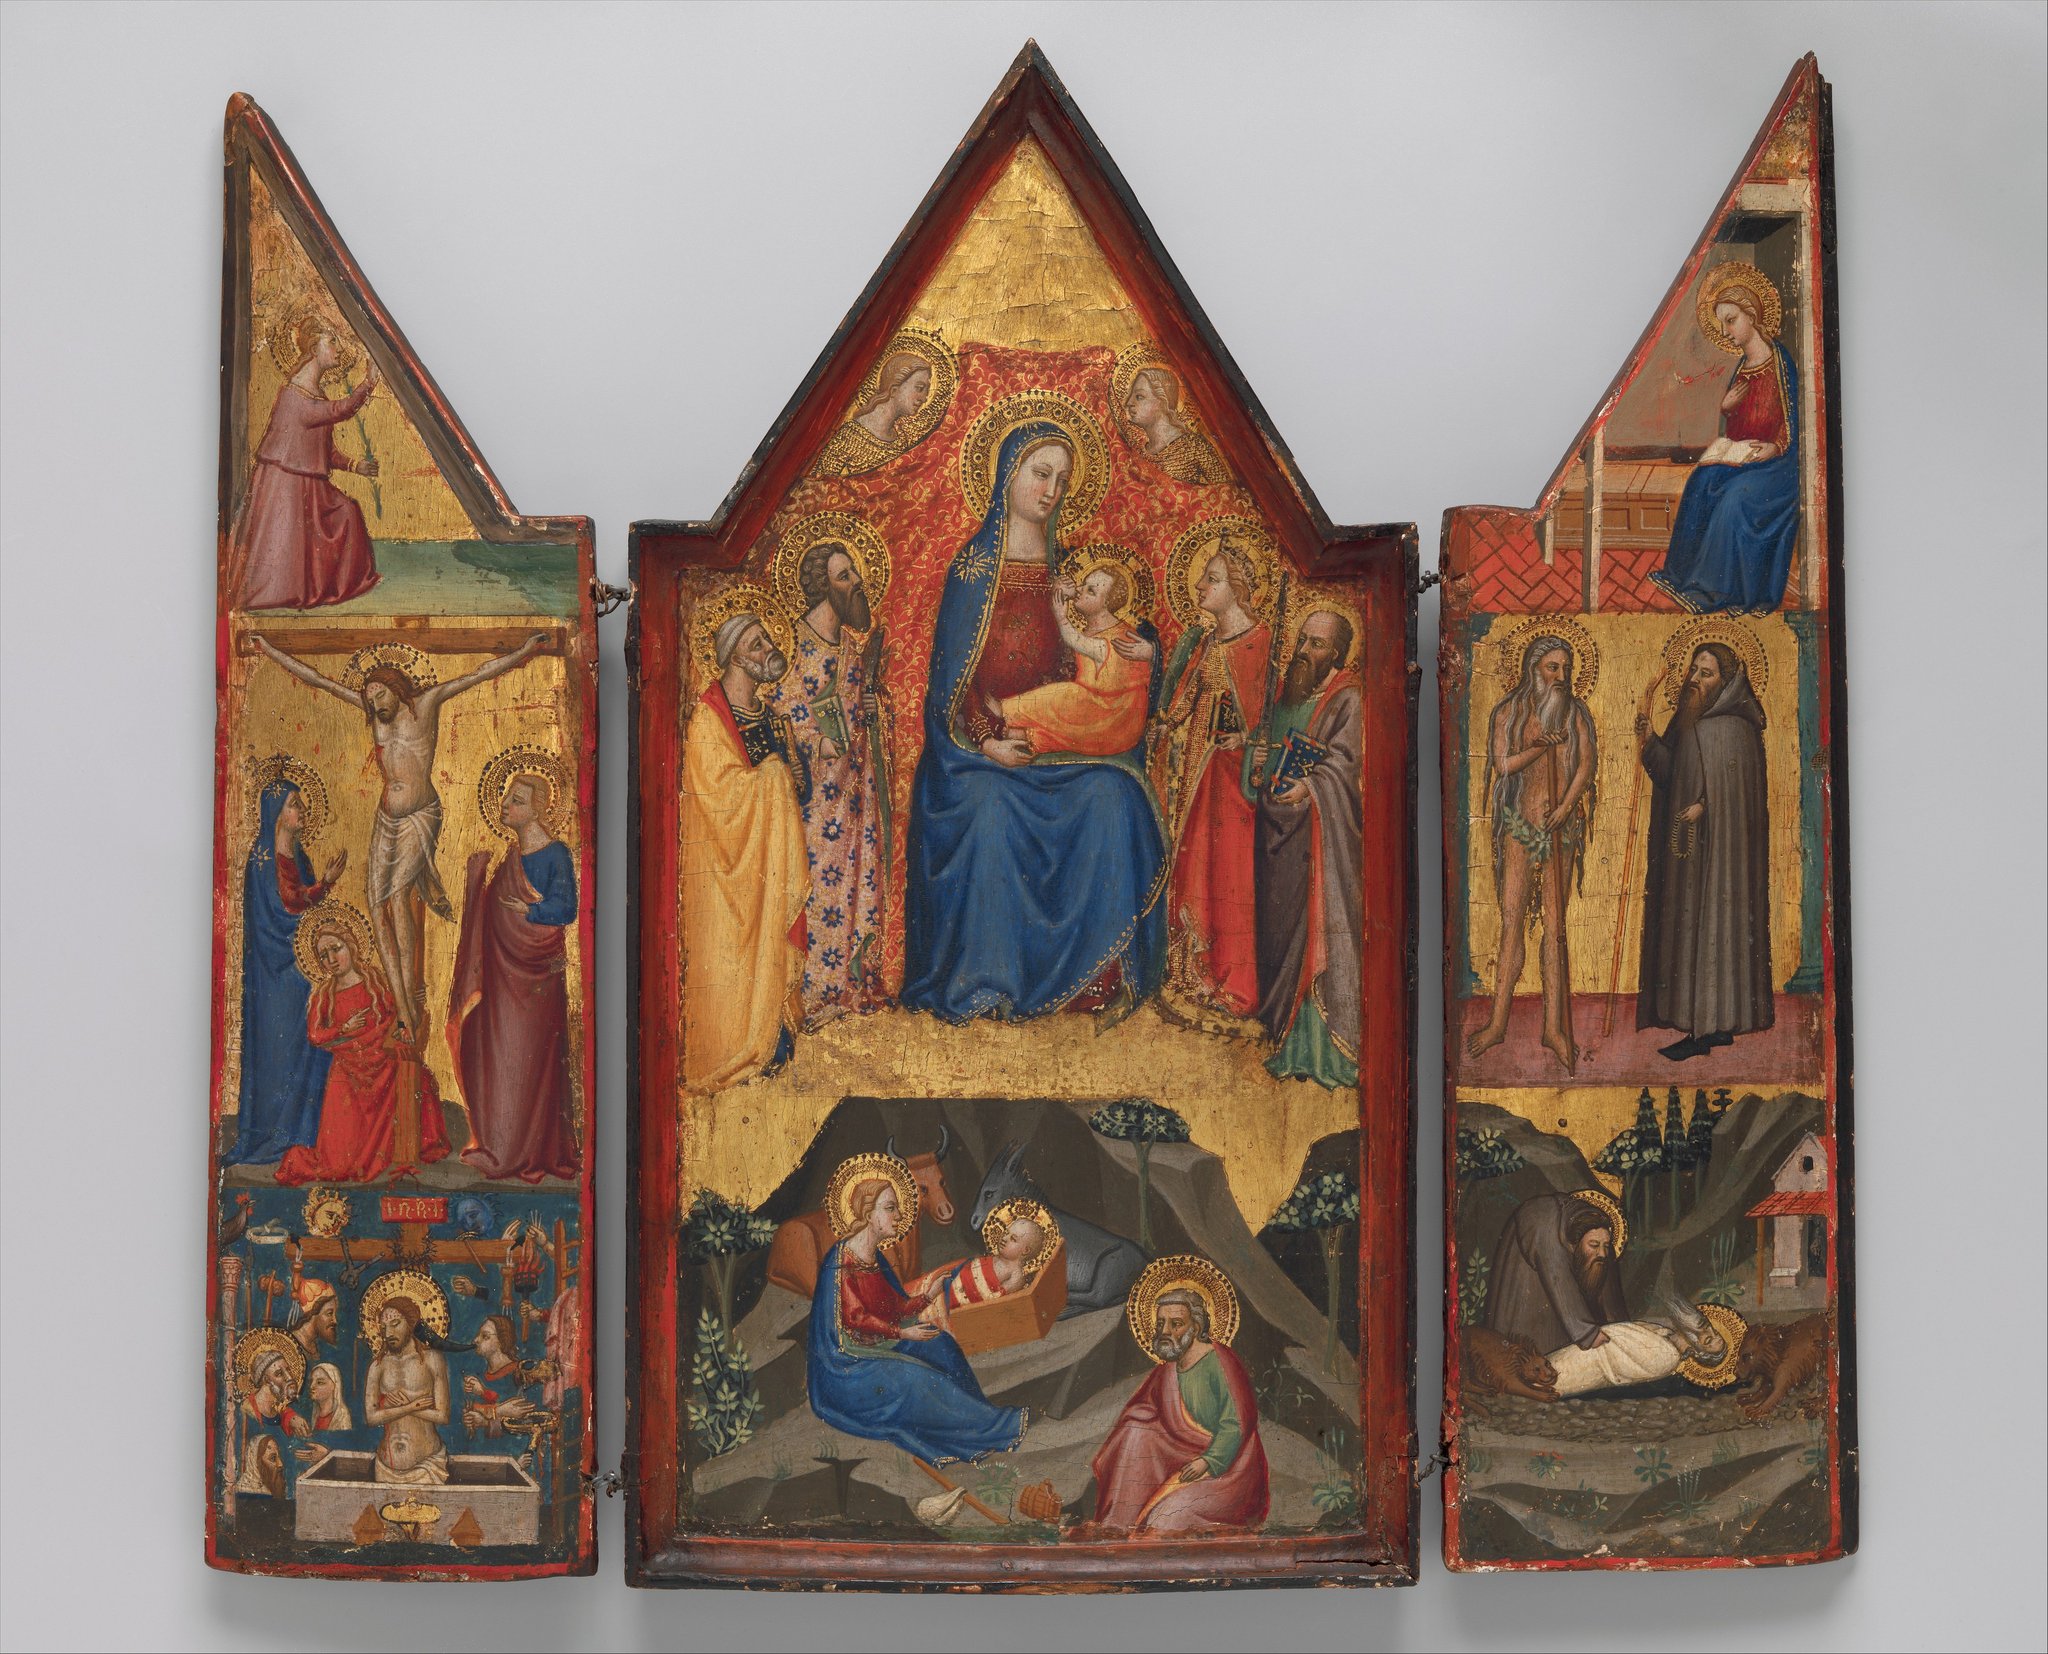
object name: triptych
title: Madonna and Child Enthroned with Saints Peter, Bartholomew, Catherine of Alexandria, and Paul, and (below) the Nativity; left wing (top to bottom): Annunciatory Angel, Crucified Christ with the Virgin, Saints Mary Magdalen and John, and Christ as the Man of Sorrows; right wing (top to bottom): Virgin Annunciate, Saints Onophrius and Paphnutius, and Saint Onophrius Buried by Saint Paphnutius.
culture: italian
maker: matteo di pacino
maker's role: artist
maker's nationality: italian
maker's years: 1359-1394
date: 1380-1390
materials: gold leaf, paint, wood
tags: madonna and child,crucifixion,nativity,saints